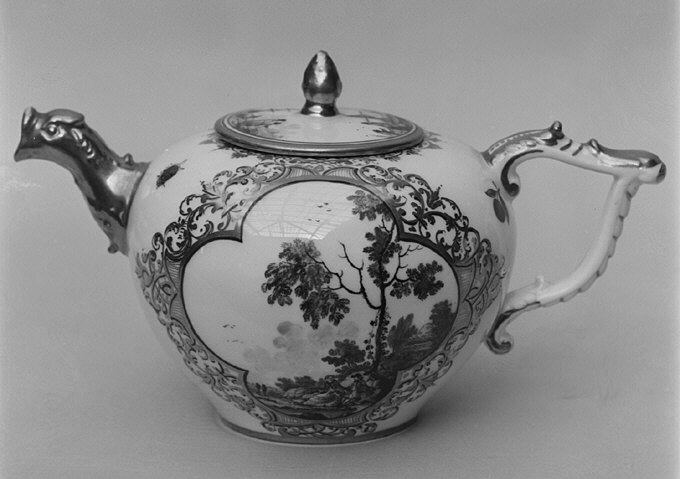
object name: teapot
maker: meissen manufactory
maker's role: manufactory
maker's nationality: german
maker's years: 1710-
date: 1740-1745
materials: hard paste porcelain